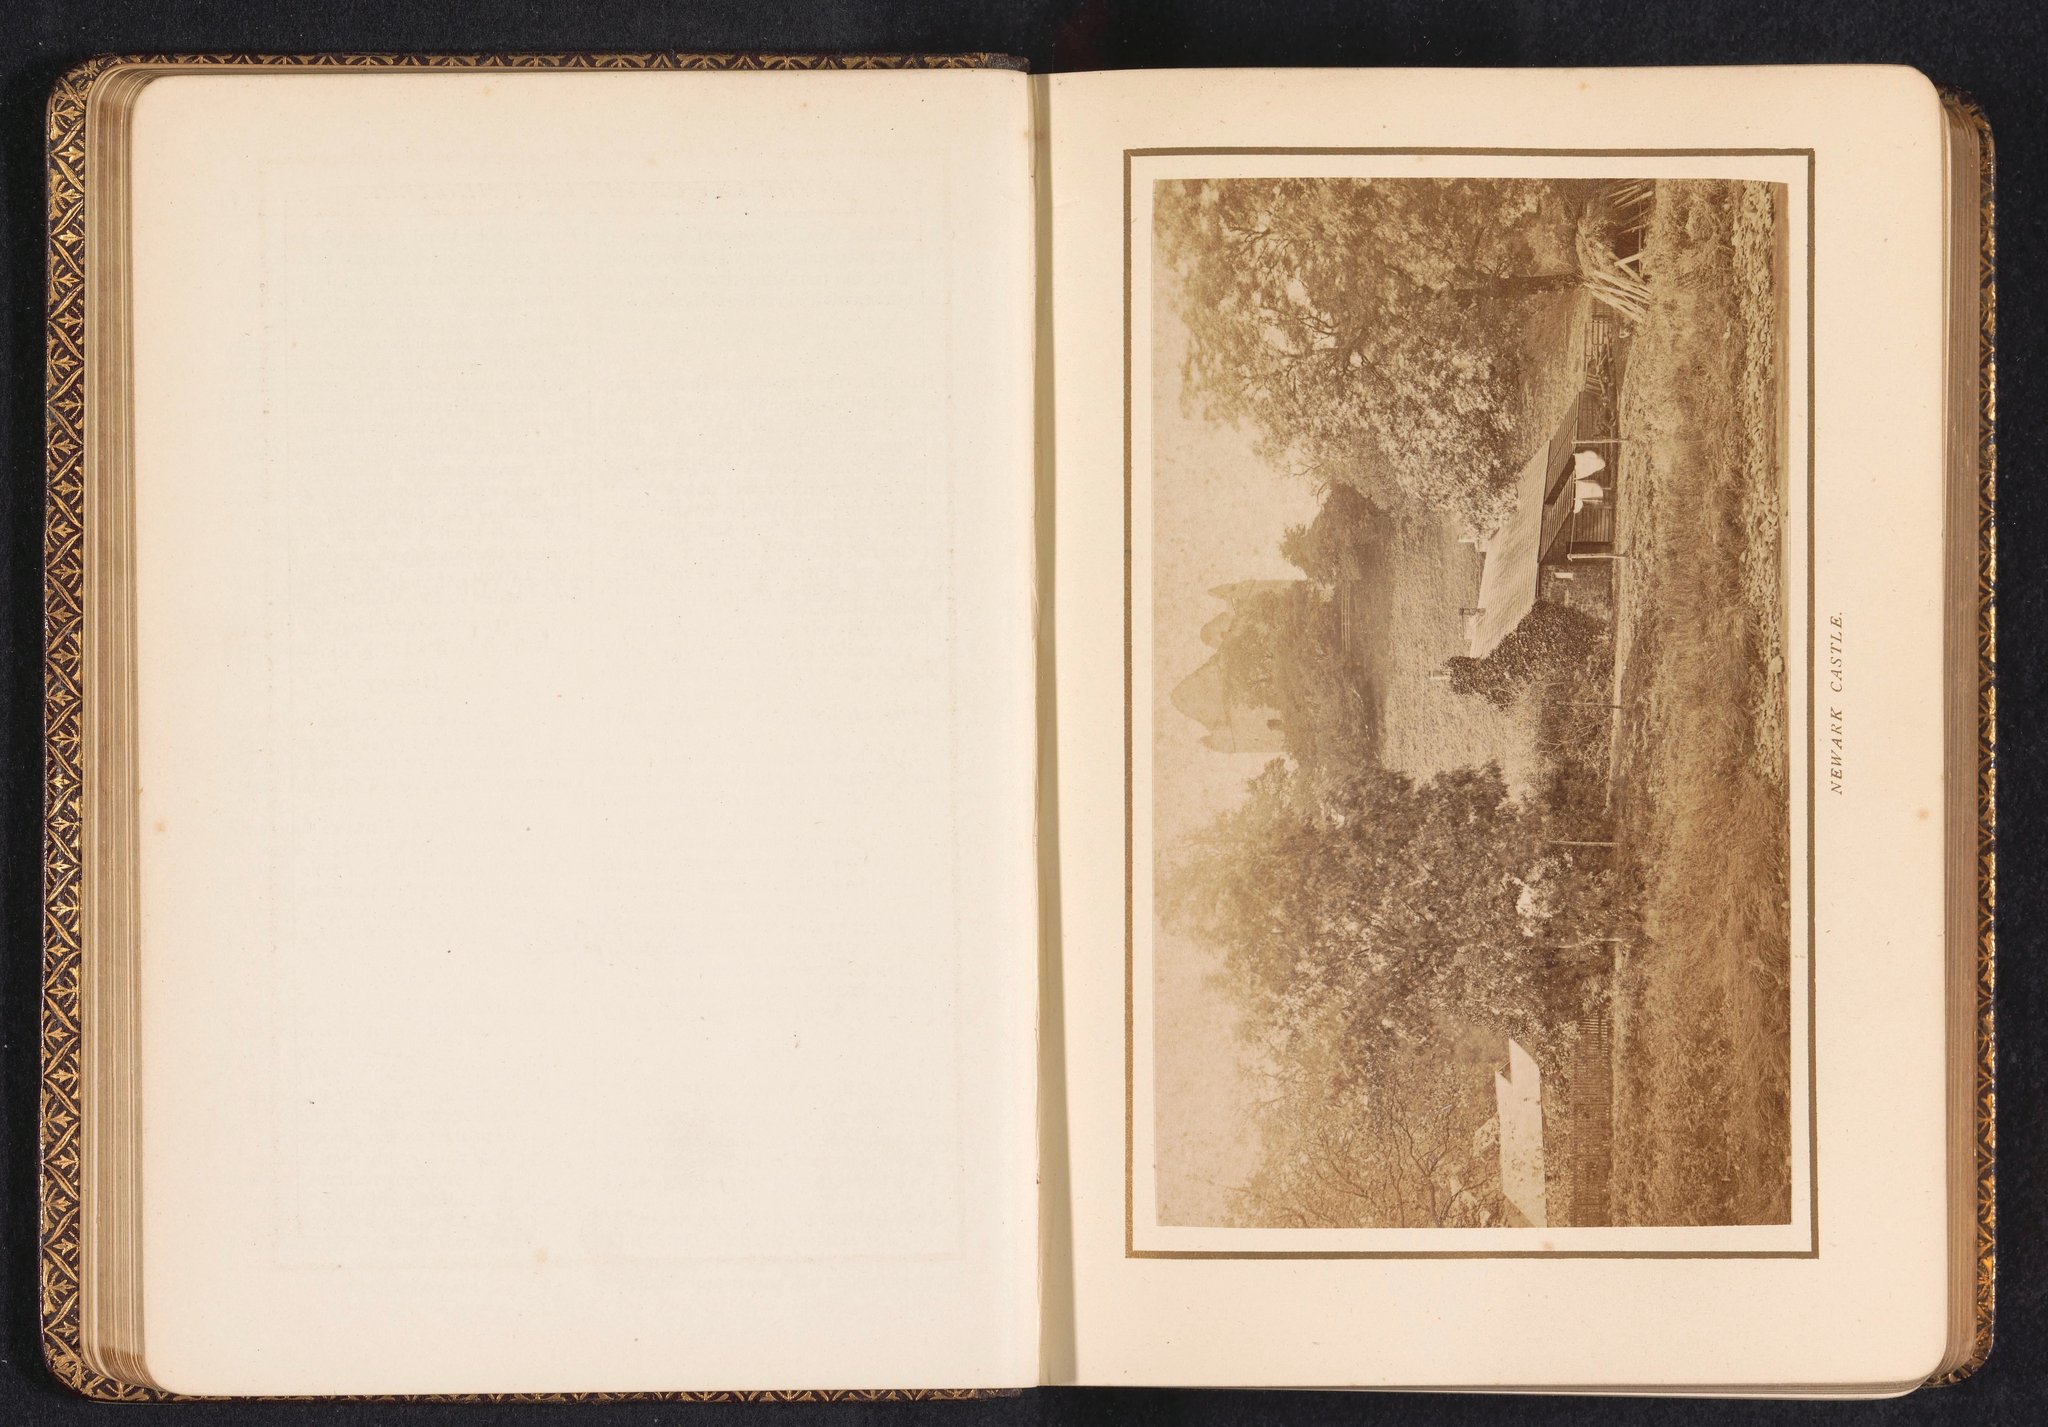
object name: photograph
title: Newark Castle.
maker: Anonymous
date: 1850-1886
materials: photographic support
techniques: albumen print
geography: scotland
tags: ruin of a dwelling, house, castle, etc.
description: Foto op tweede ongenummerde pagina na pagina 44.